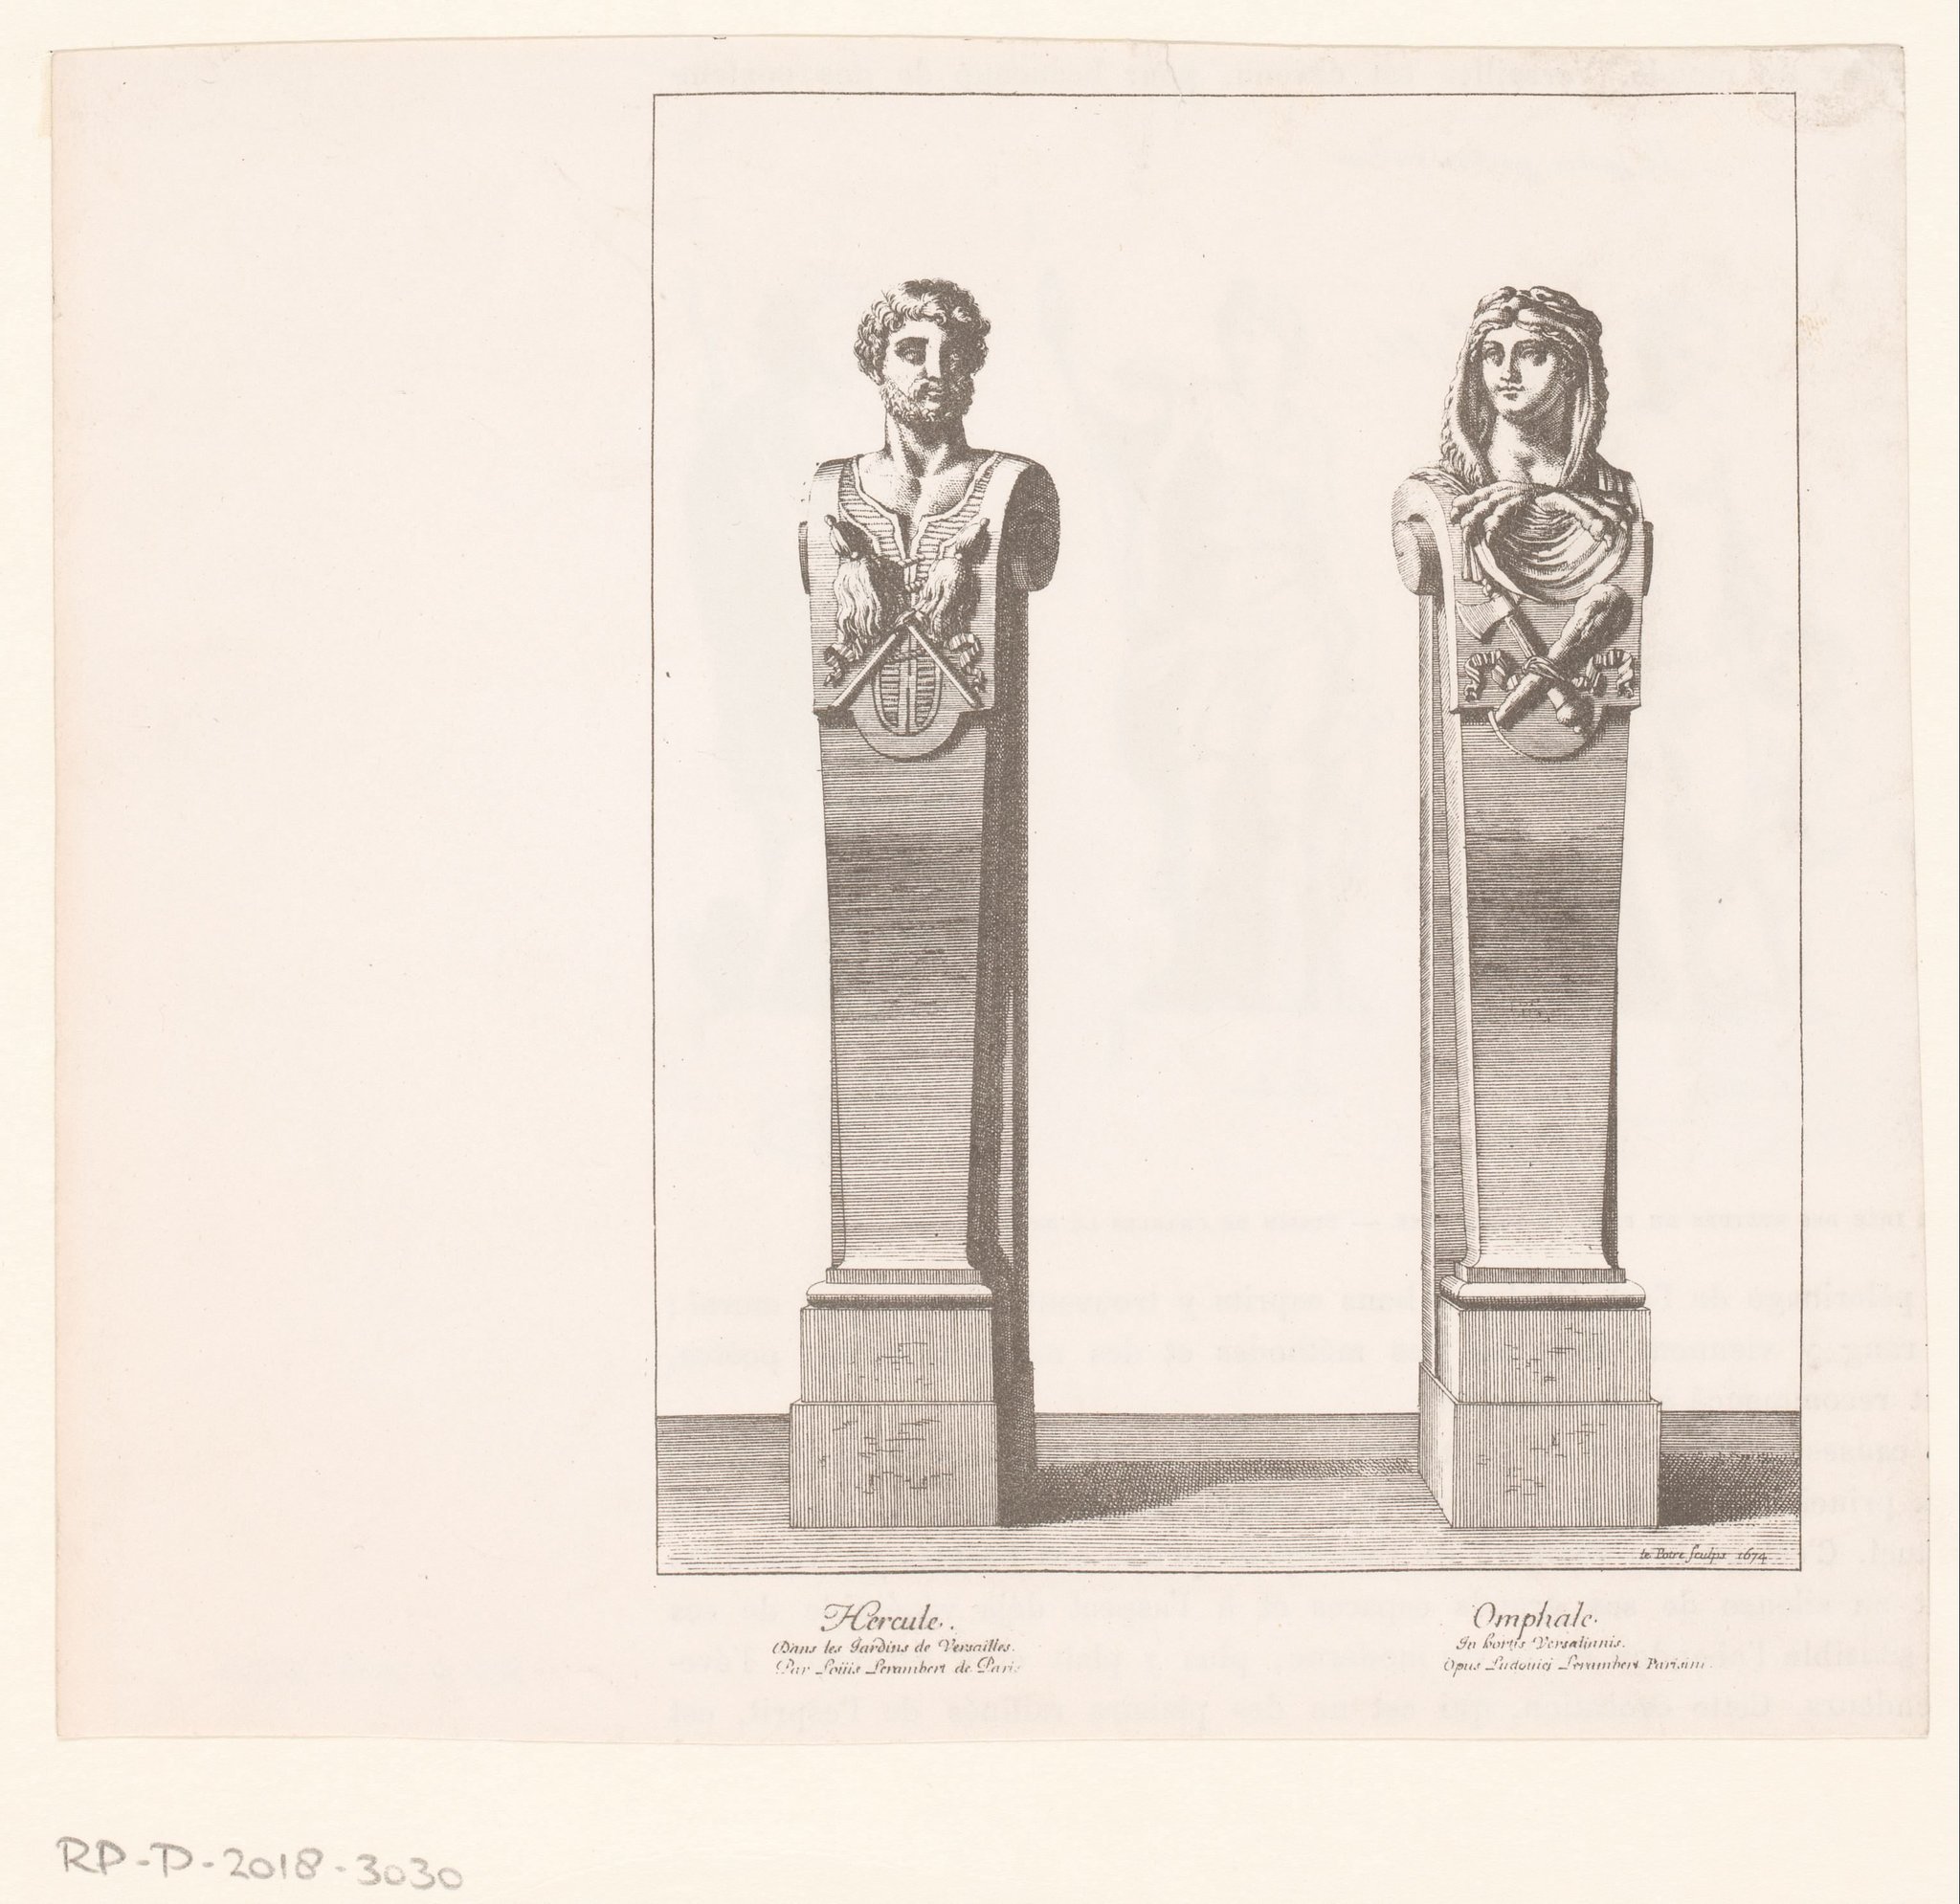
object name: photomechanical print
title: Twee hermen: Hercules en Omphale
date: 1674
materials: paper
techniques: letterpress printing, photolithography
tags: herms (garden ornaments), hercules in love with omphale; the hero is set to spin wool or to do other women's work among the servants, while omphale wears his lion's skin and wields his club and bow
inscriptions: collector's mark: Lugt 2228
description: Hercules met op de sokkel weefstokken. Omphale met het leeuwenvel van Hercules om haar hoofd en schouders, en op de sokkel de knots van Hercules. Op verso fragment van een afbeelding: kopie van een prent met daarop de dagdelen (drie van vier zichtbaar).